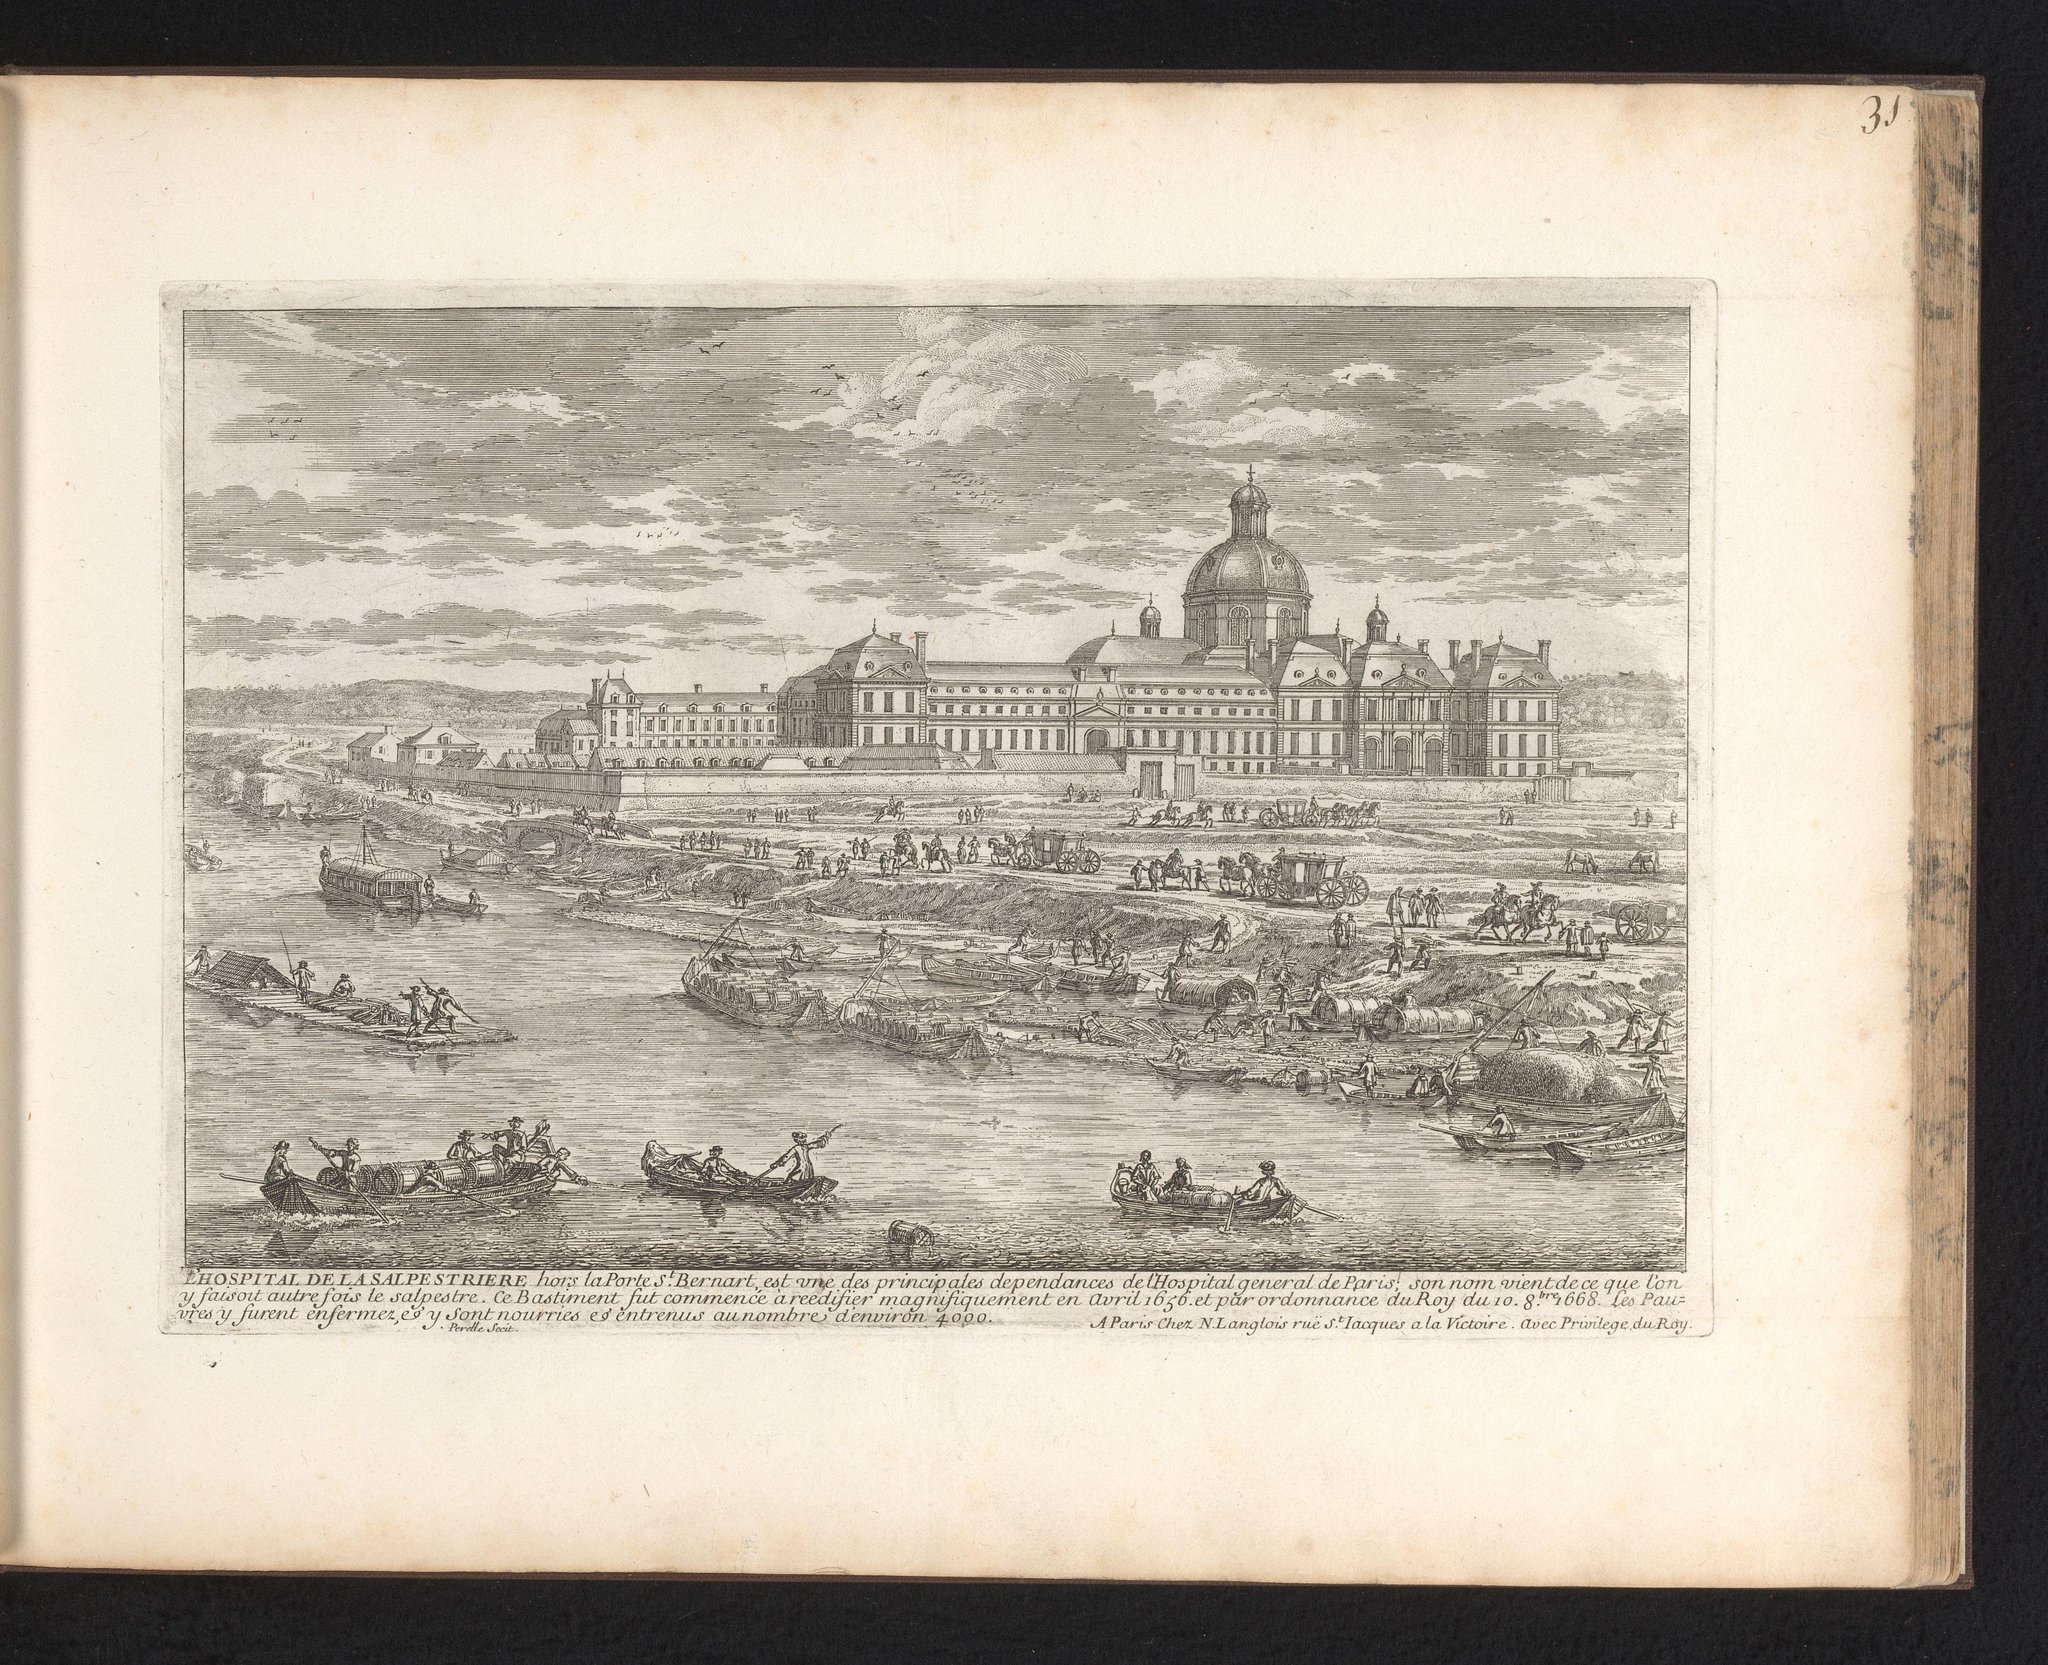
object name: print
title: Stadsgezichten en landschappen in Frankrijk en Italië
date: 1677-1695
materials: paper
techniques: etching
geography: france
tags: city-view, and landscape with man-made constructions, hospital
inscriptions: collector's mark: Lugt 2228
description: Prenten met het signatuur 'Perelle' kunnen zowel door vader Gabriel als door zonen Nicolas en Adam gemaakt zijn. De uitgevers vader en zoon Nicolas Langlois worden allebei vermeld als N. Langlois op hetzelfde adres.